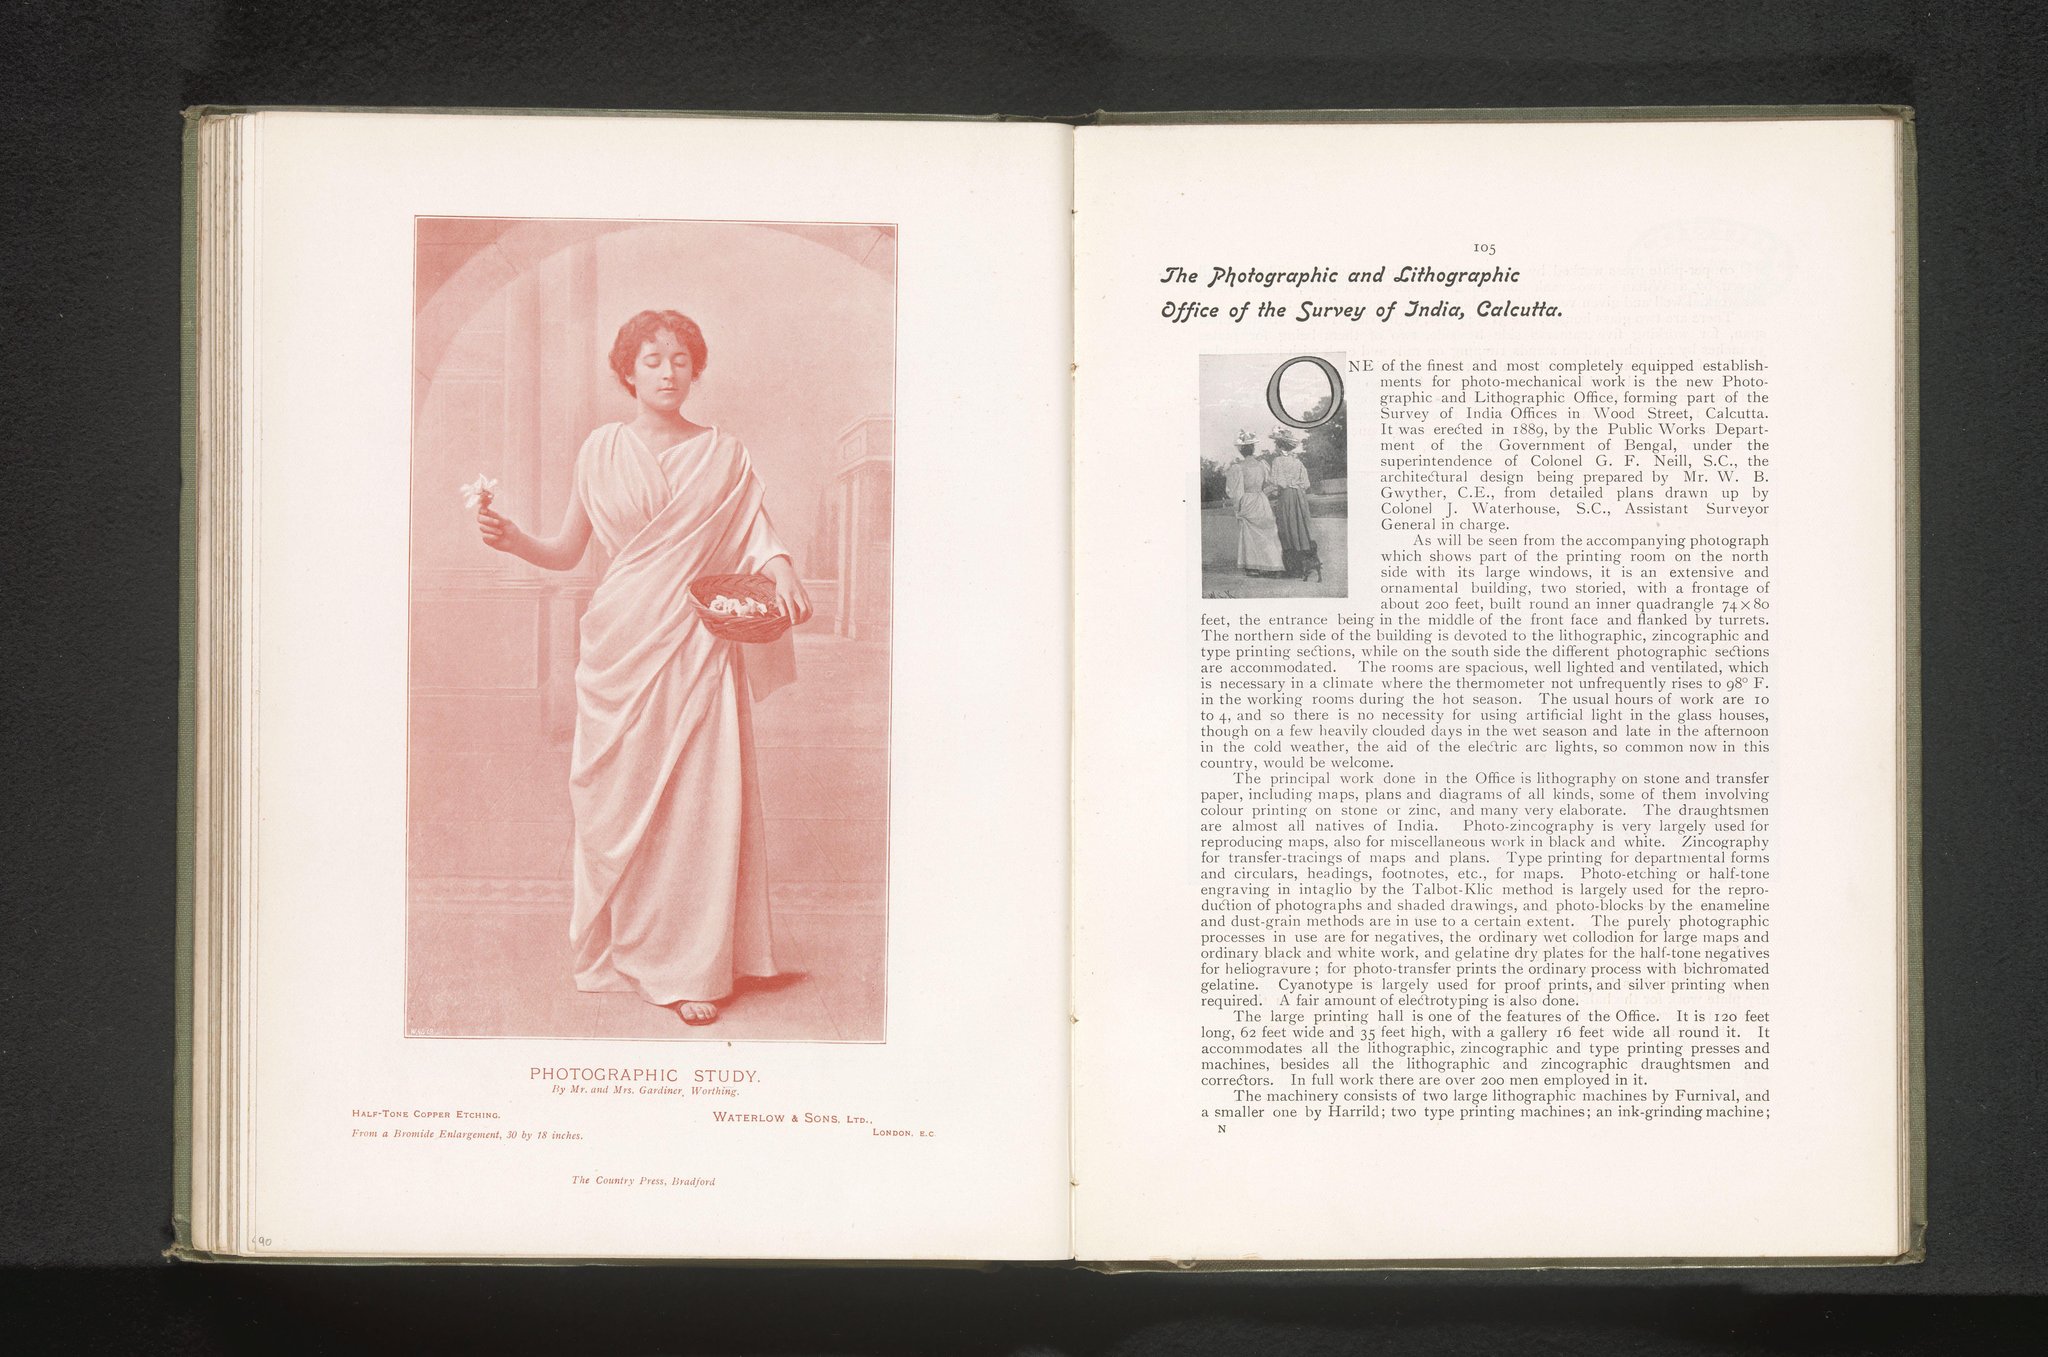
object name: photomechanical print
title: Portret van een onbekende vrouw met bloemen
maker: Anonymous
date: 1893-1898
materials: paper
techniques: autotype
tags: historical persons - bb - woman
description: Prent op zesde ongenummerde pagina na pagina 104.